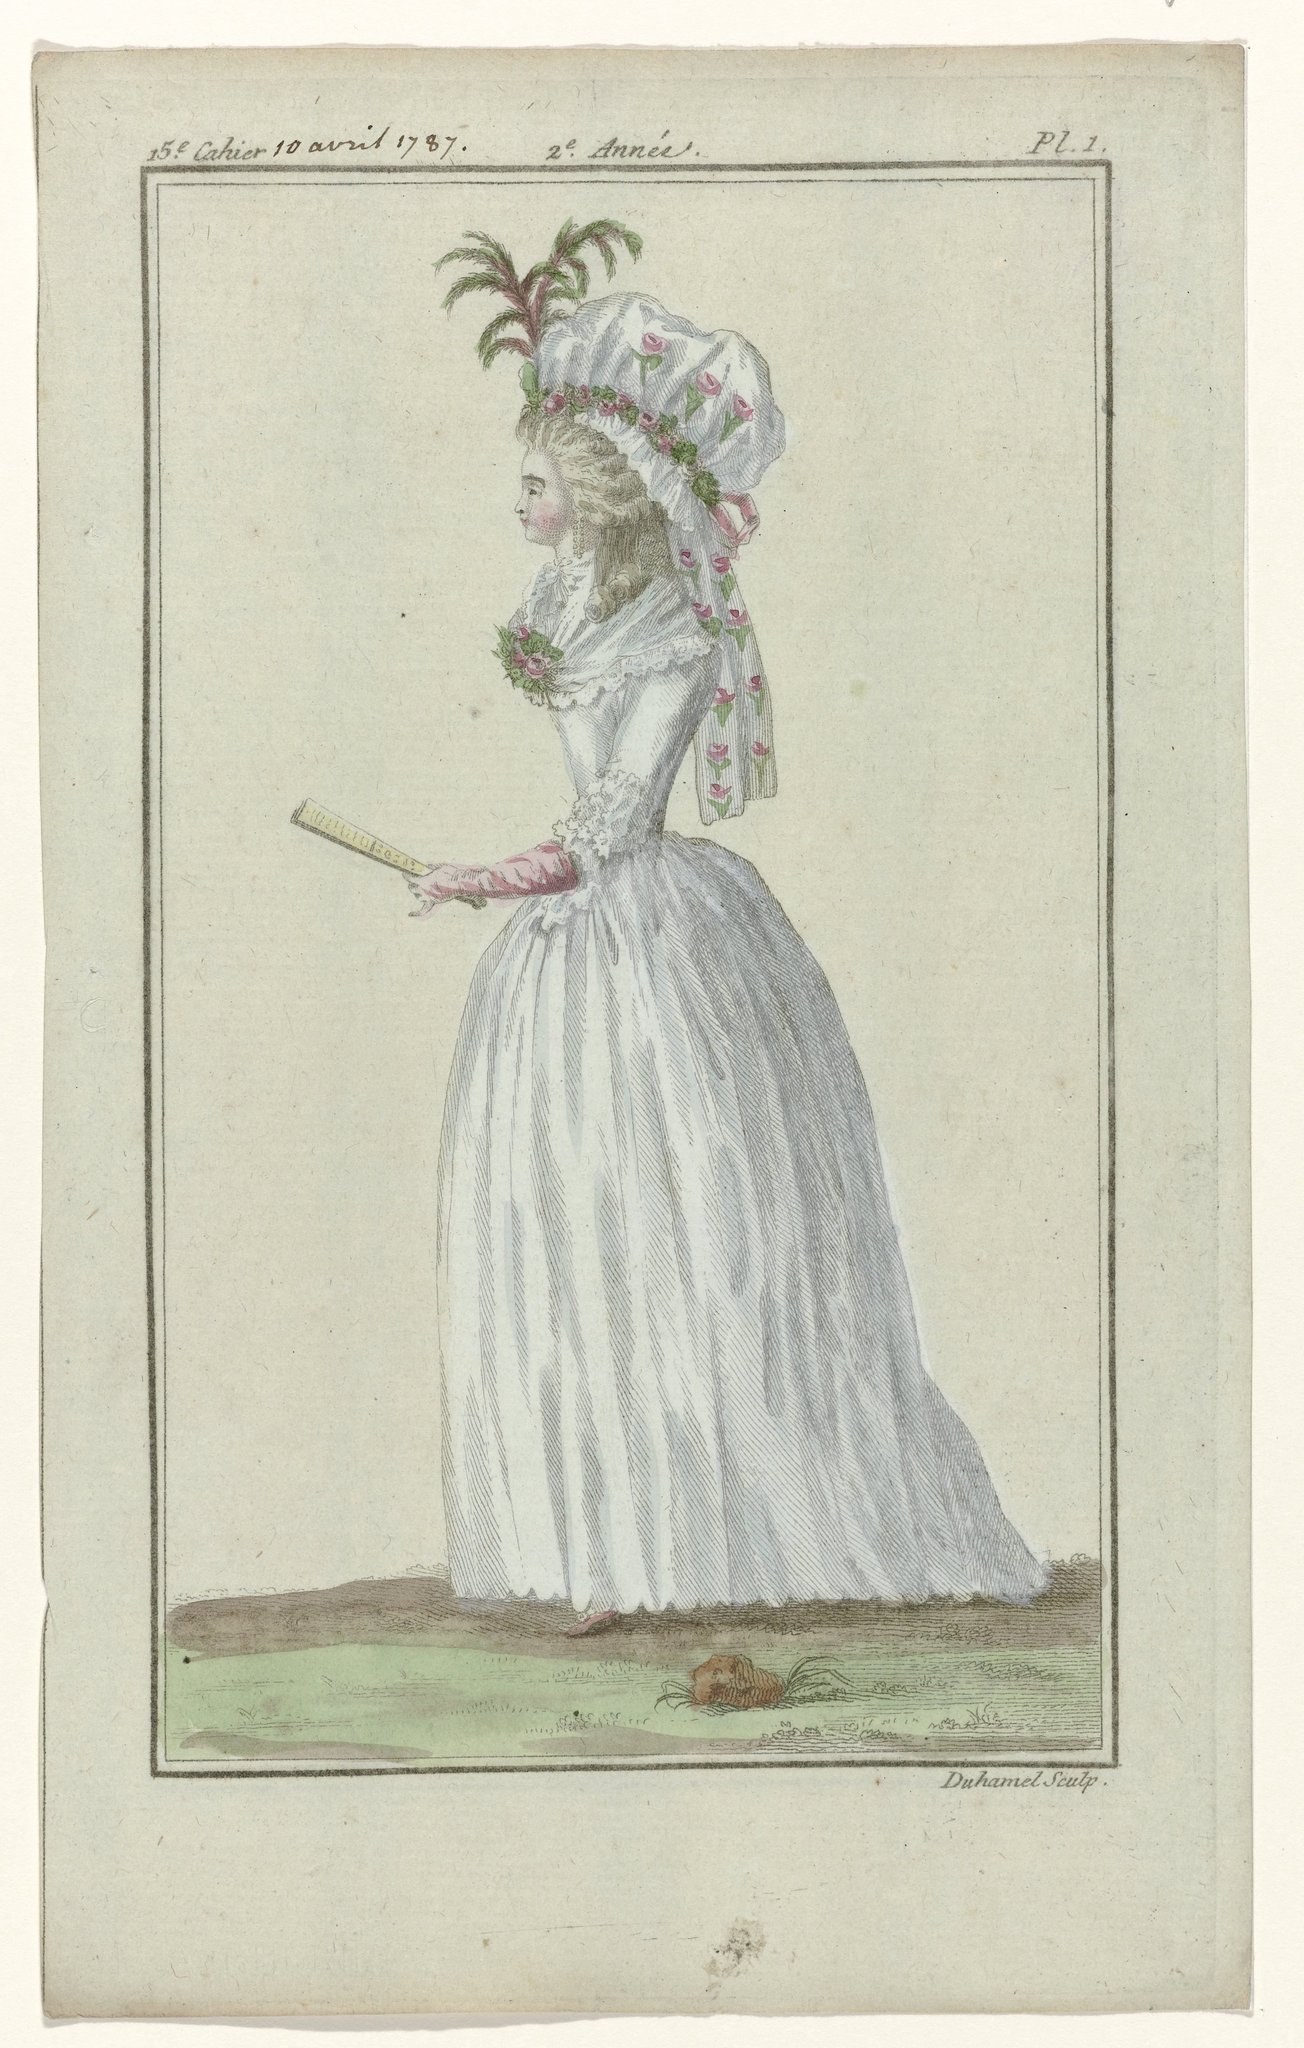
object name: fashion print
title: Magasin des Modes Nouvelles Françaises et Anglaises, 10 avril 1787, 15e cahier, 2e année, Pl. 1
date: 1787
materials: paper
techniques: engraving, hand coloring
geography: paris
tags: corsage (+ women's clothes), ear-rings (+ women's clothes), gloves, mittens (long gloves) (+ women's clothes), dress, gown (fourreau) (+ women's clothes), head-gear: cap (+ women's clothes), fashion plates, fan (+ women's clothes), piece of clothing covering the breast or décolleté (fichu) (+ women's clothes)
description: Ongetrouwde jonge vrouw, lopend naar links, gekleed in een fourreau of japon van linnen met geschulpte zoom. Om de hals een fichu. Op het hoofd een muts van tule: bonnet à la Béarnaise, met ingeweven gekleurde bloemen. Verdere accessoires: oorbel, bloemcorsage, lange handschoenen, waaier, schoen met rozet(?) en hak. De prent maakt deel uit van het 15e Cahier, 2e année, uit de serie Magasin des Modes Nouvelles Françaises et Anglaises. De serie bestaat uit 172 modeprenten, uitgegeven door Buisson, Parijs, 20 november 1786 - 21 décembre 1789.